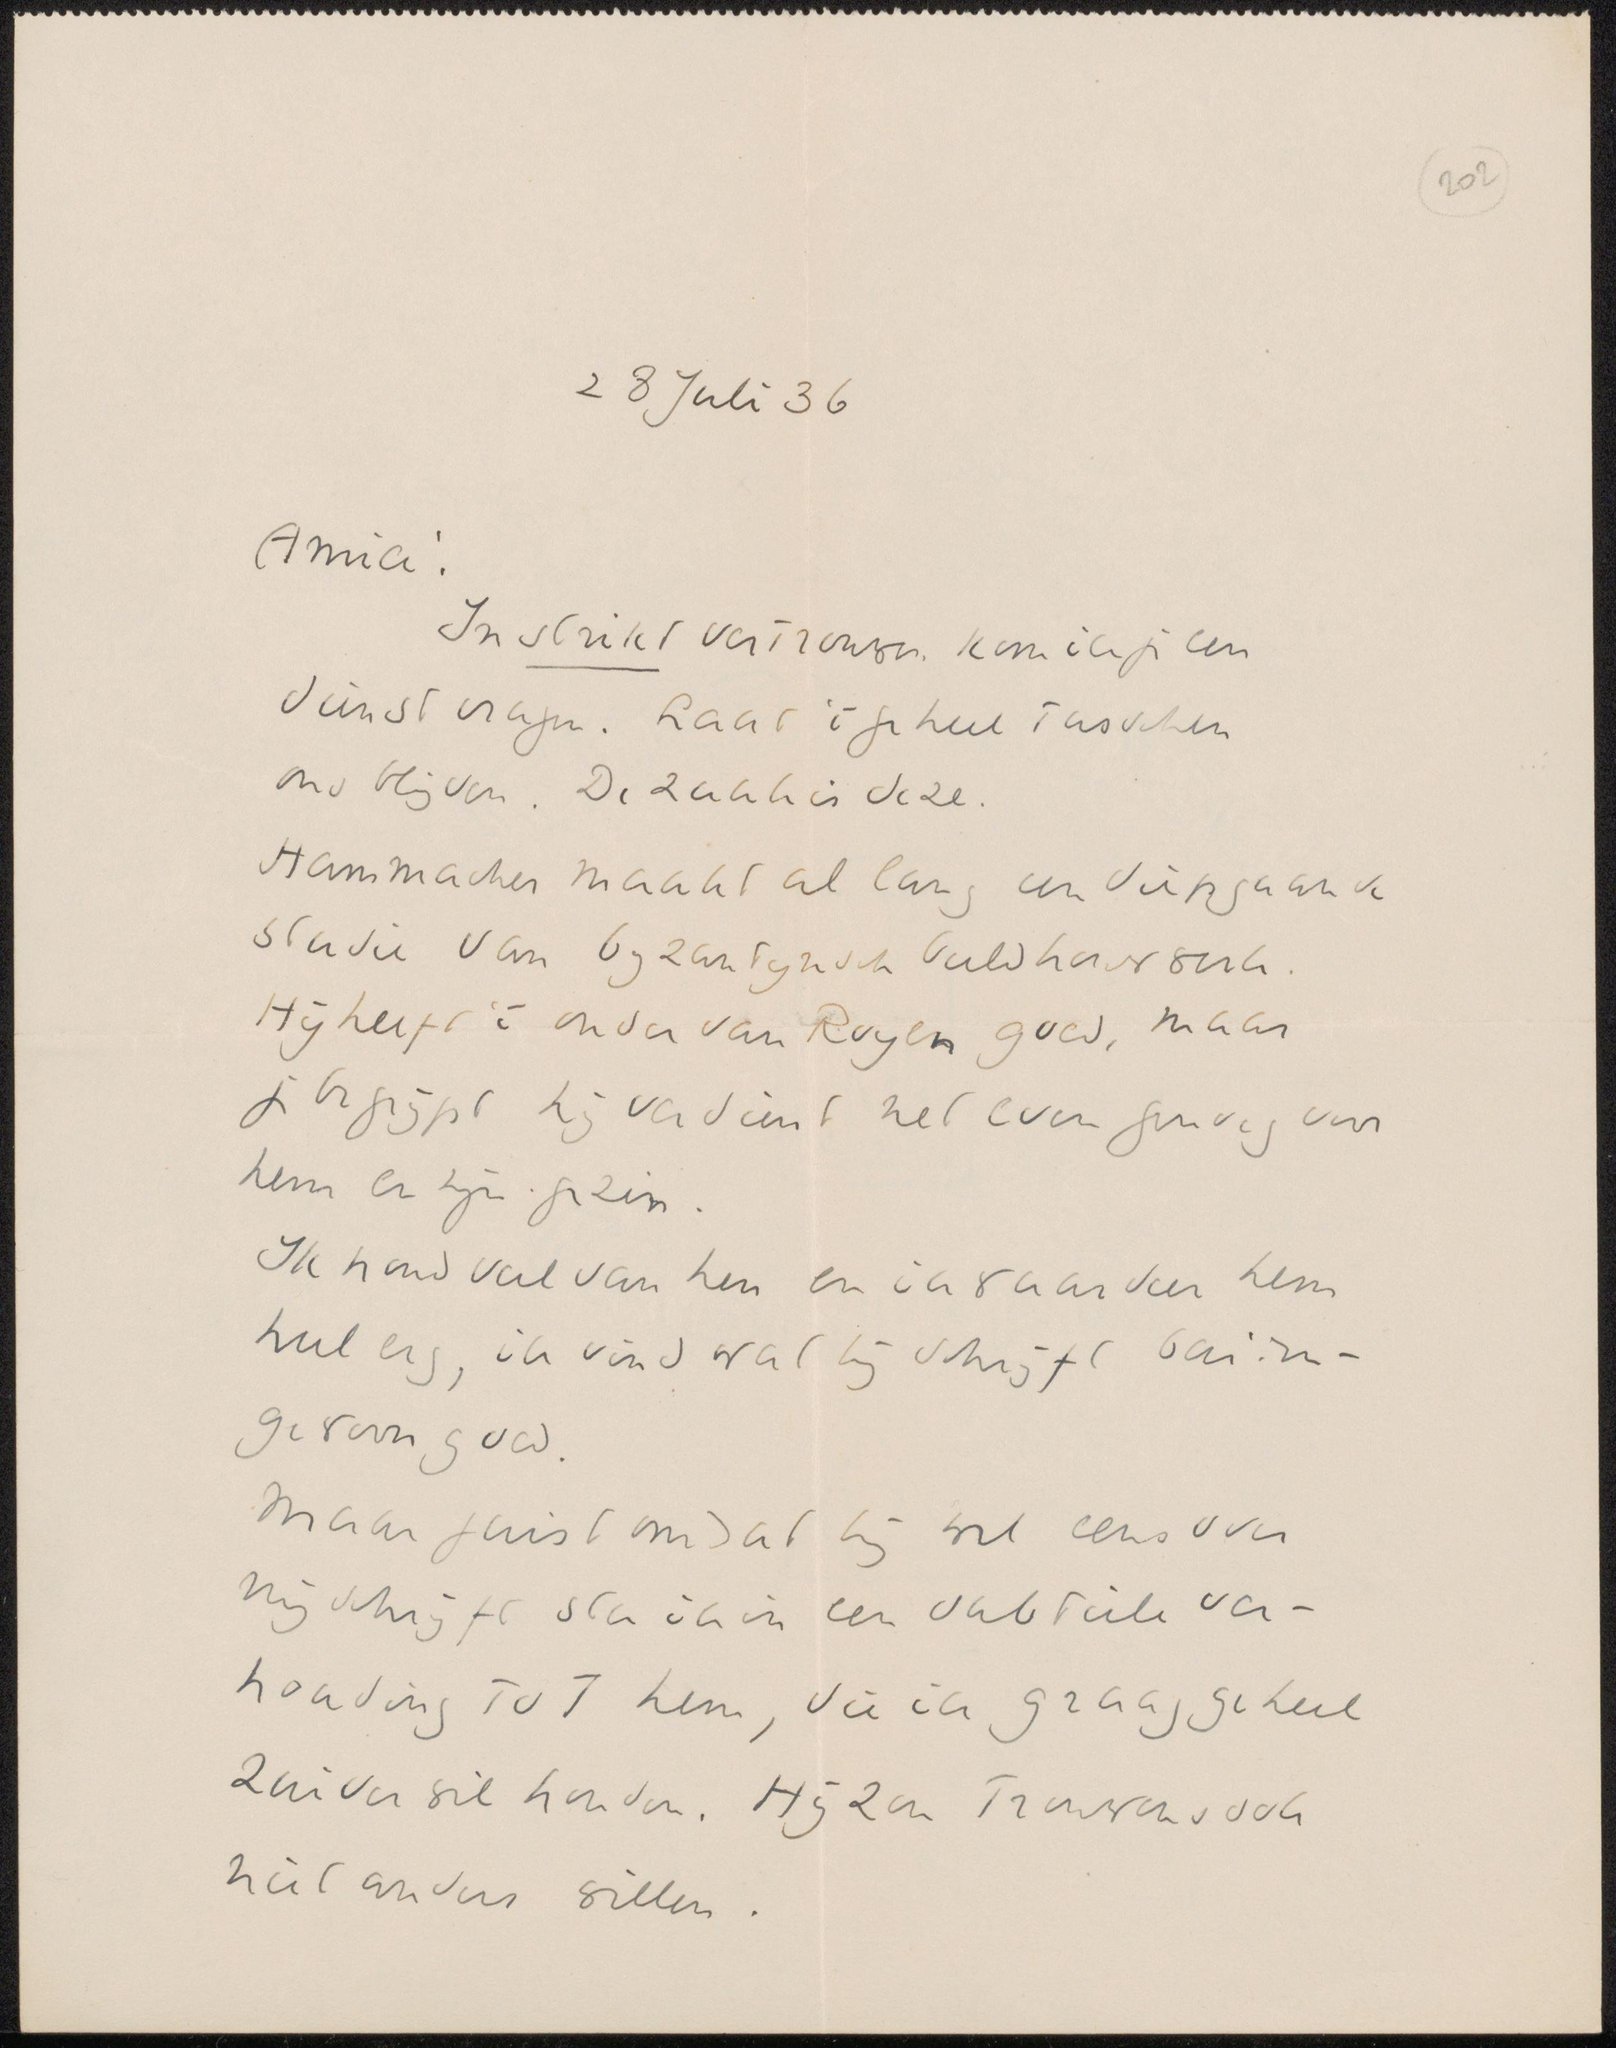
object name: letter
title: Brief aan Willem Bogtman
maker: richard nicolaüs roland holst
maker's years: 1868-1938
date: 1936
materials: ink, paper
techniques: pen, writing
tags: willem bogtman, arnhem, printer, middelburg, bram hammacher, money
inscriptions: watermark